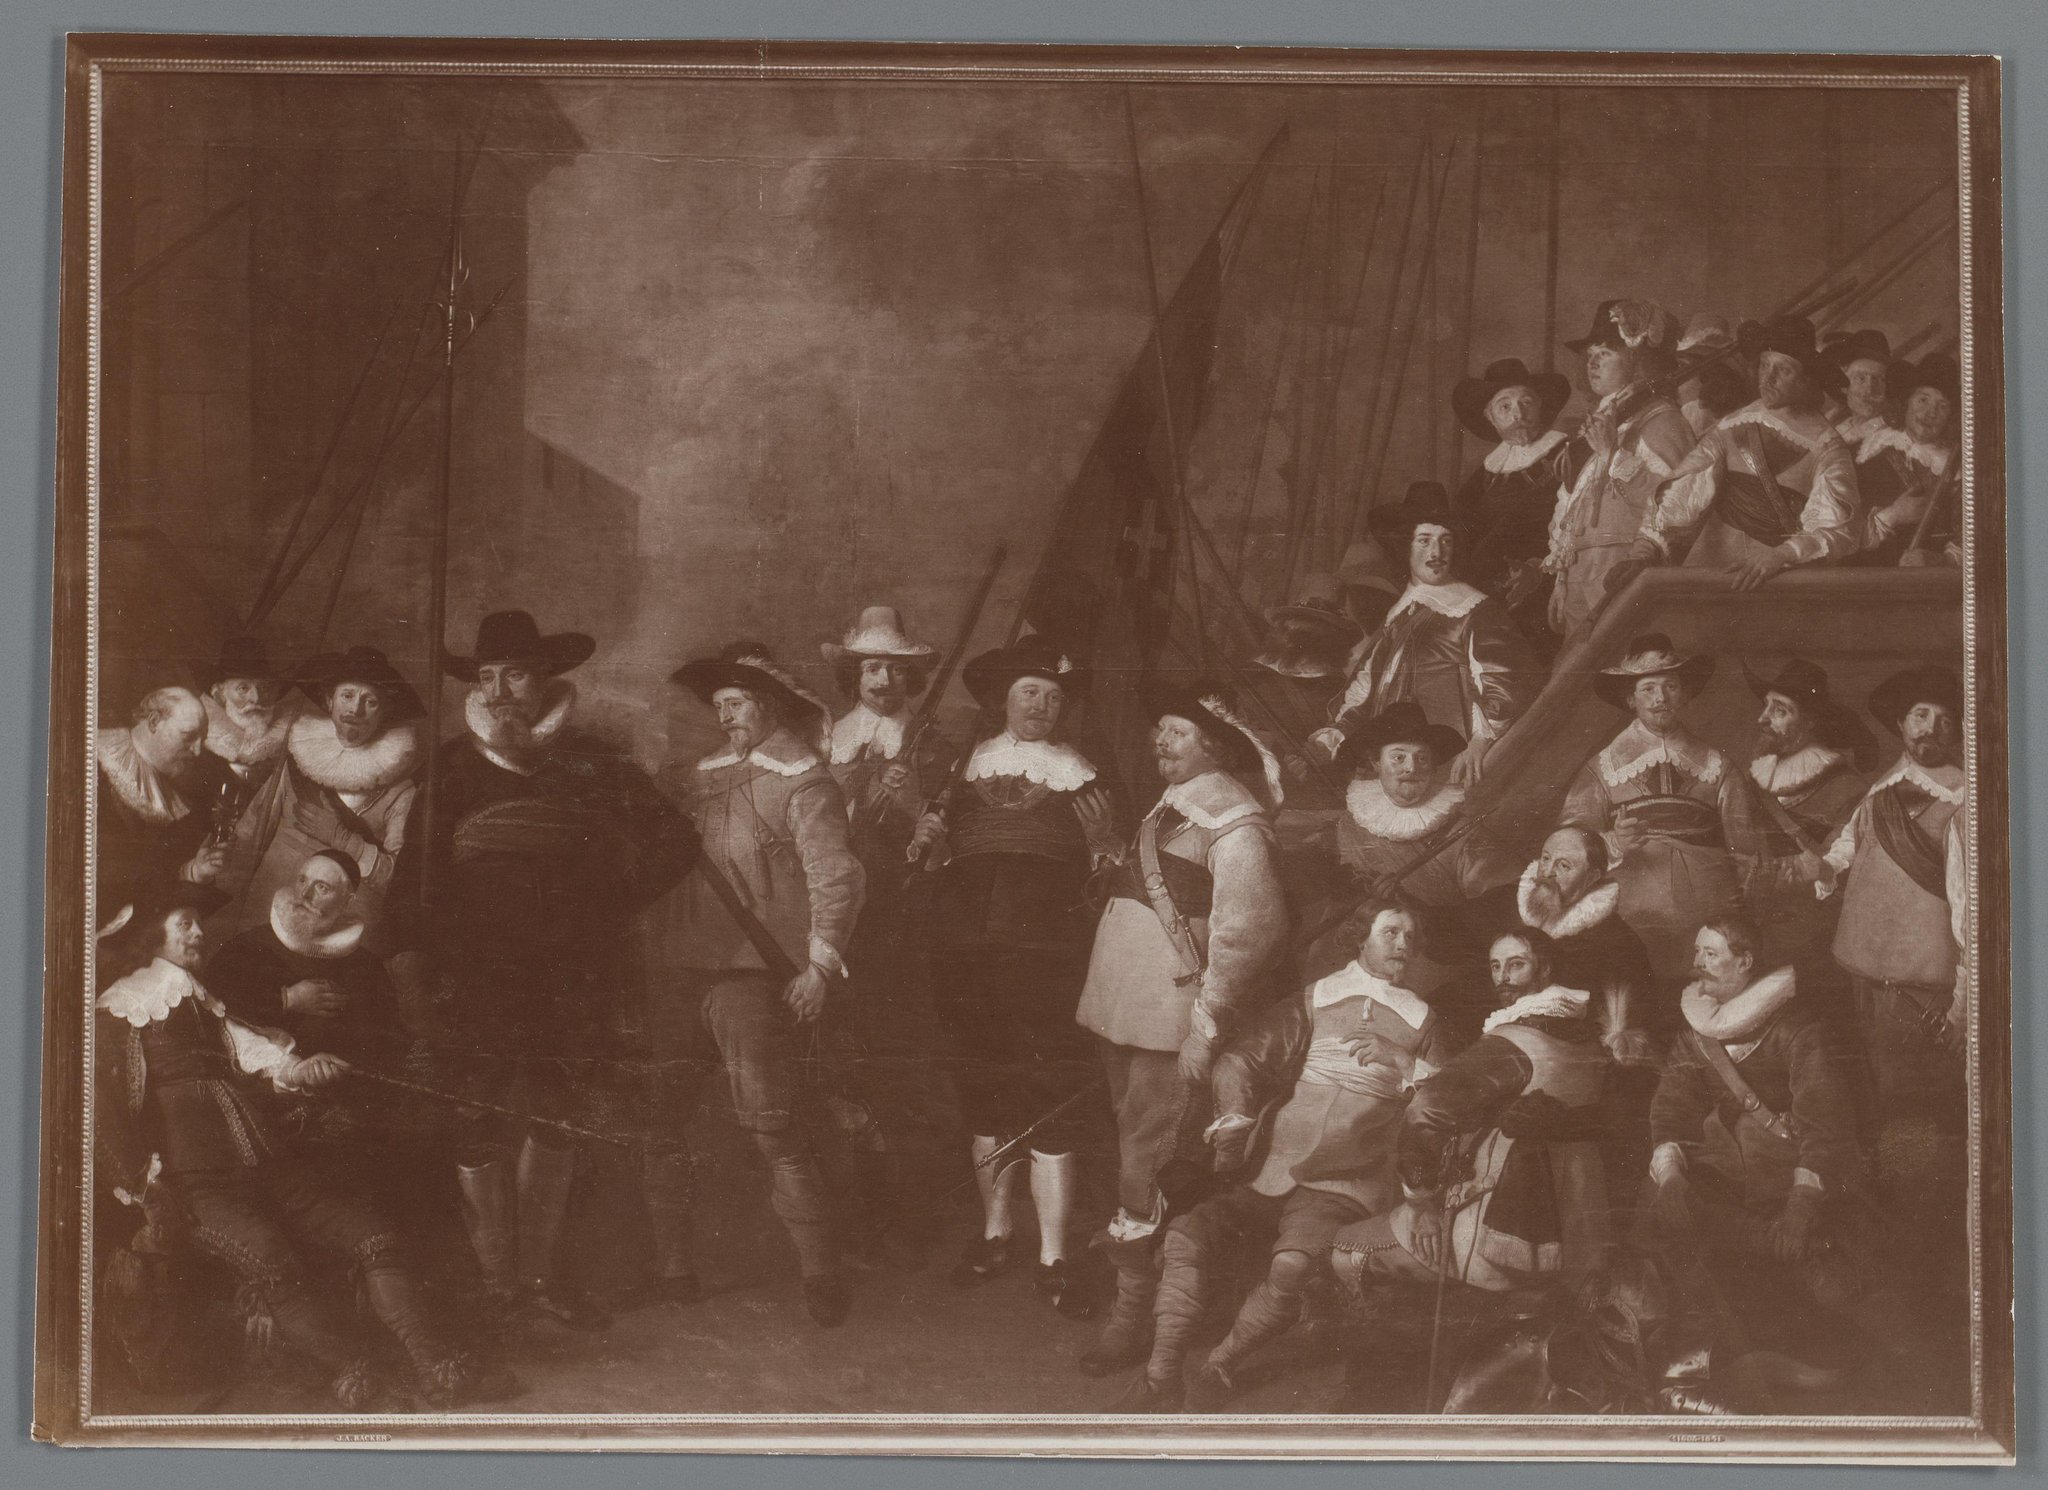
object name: photograph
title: Fotoreproductie van schilderij van Officieren en andere schutters van wijk V in Amsterdam, door Jacob Adriaensz. Backer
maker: Anonymous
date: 1880-1920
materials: paper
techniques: collodion silver print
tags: amsterdam, mayor, cornelis de graeff, night patrol, public safety, guard duty, keeping sentry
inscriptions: number: ‘580’, inscription: ‘JA Backer/ Schutterstuk Cloveniersdoelen’